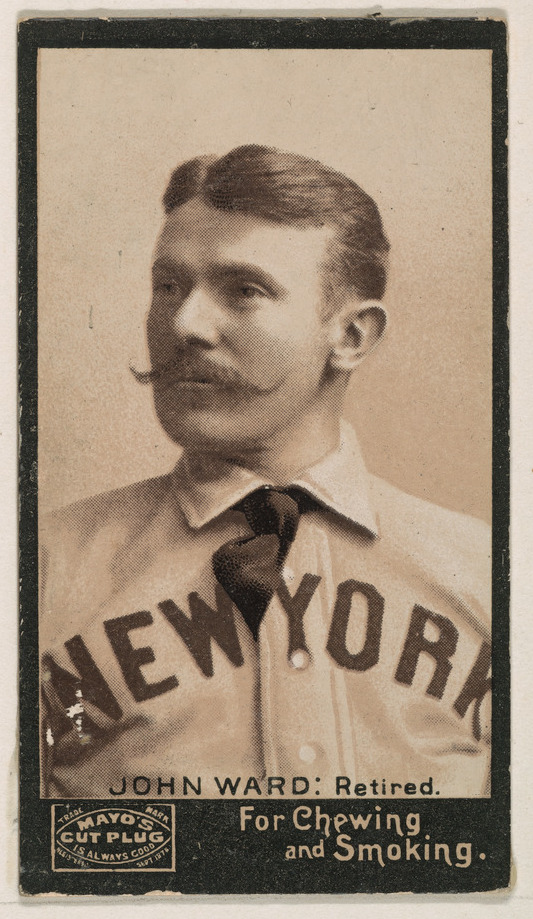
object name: print, baseball card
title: John Ward, Retired, New York, from the Mayo's Cut Plug Baseball series (N300)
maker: p.h. mayo & brother, richmond, virginia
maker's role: publisher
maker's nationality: american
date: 1895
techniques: lithography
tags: men,portraits,baseball,athletes